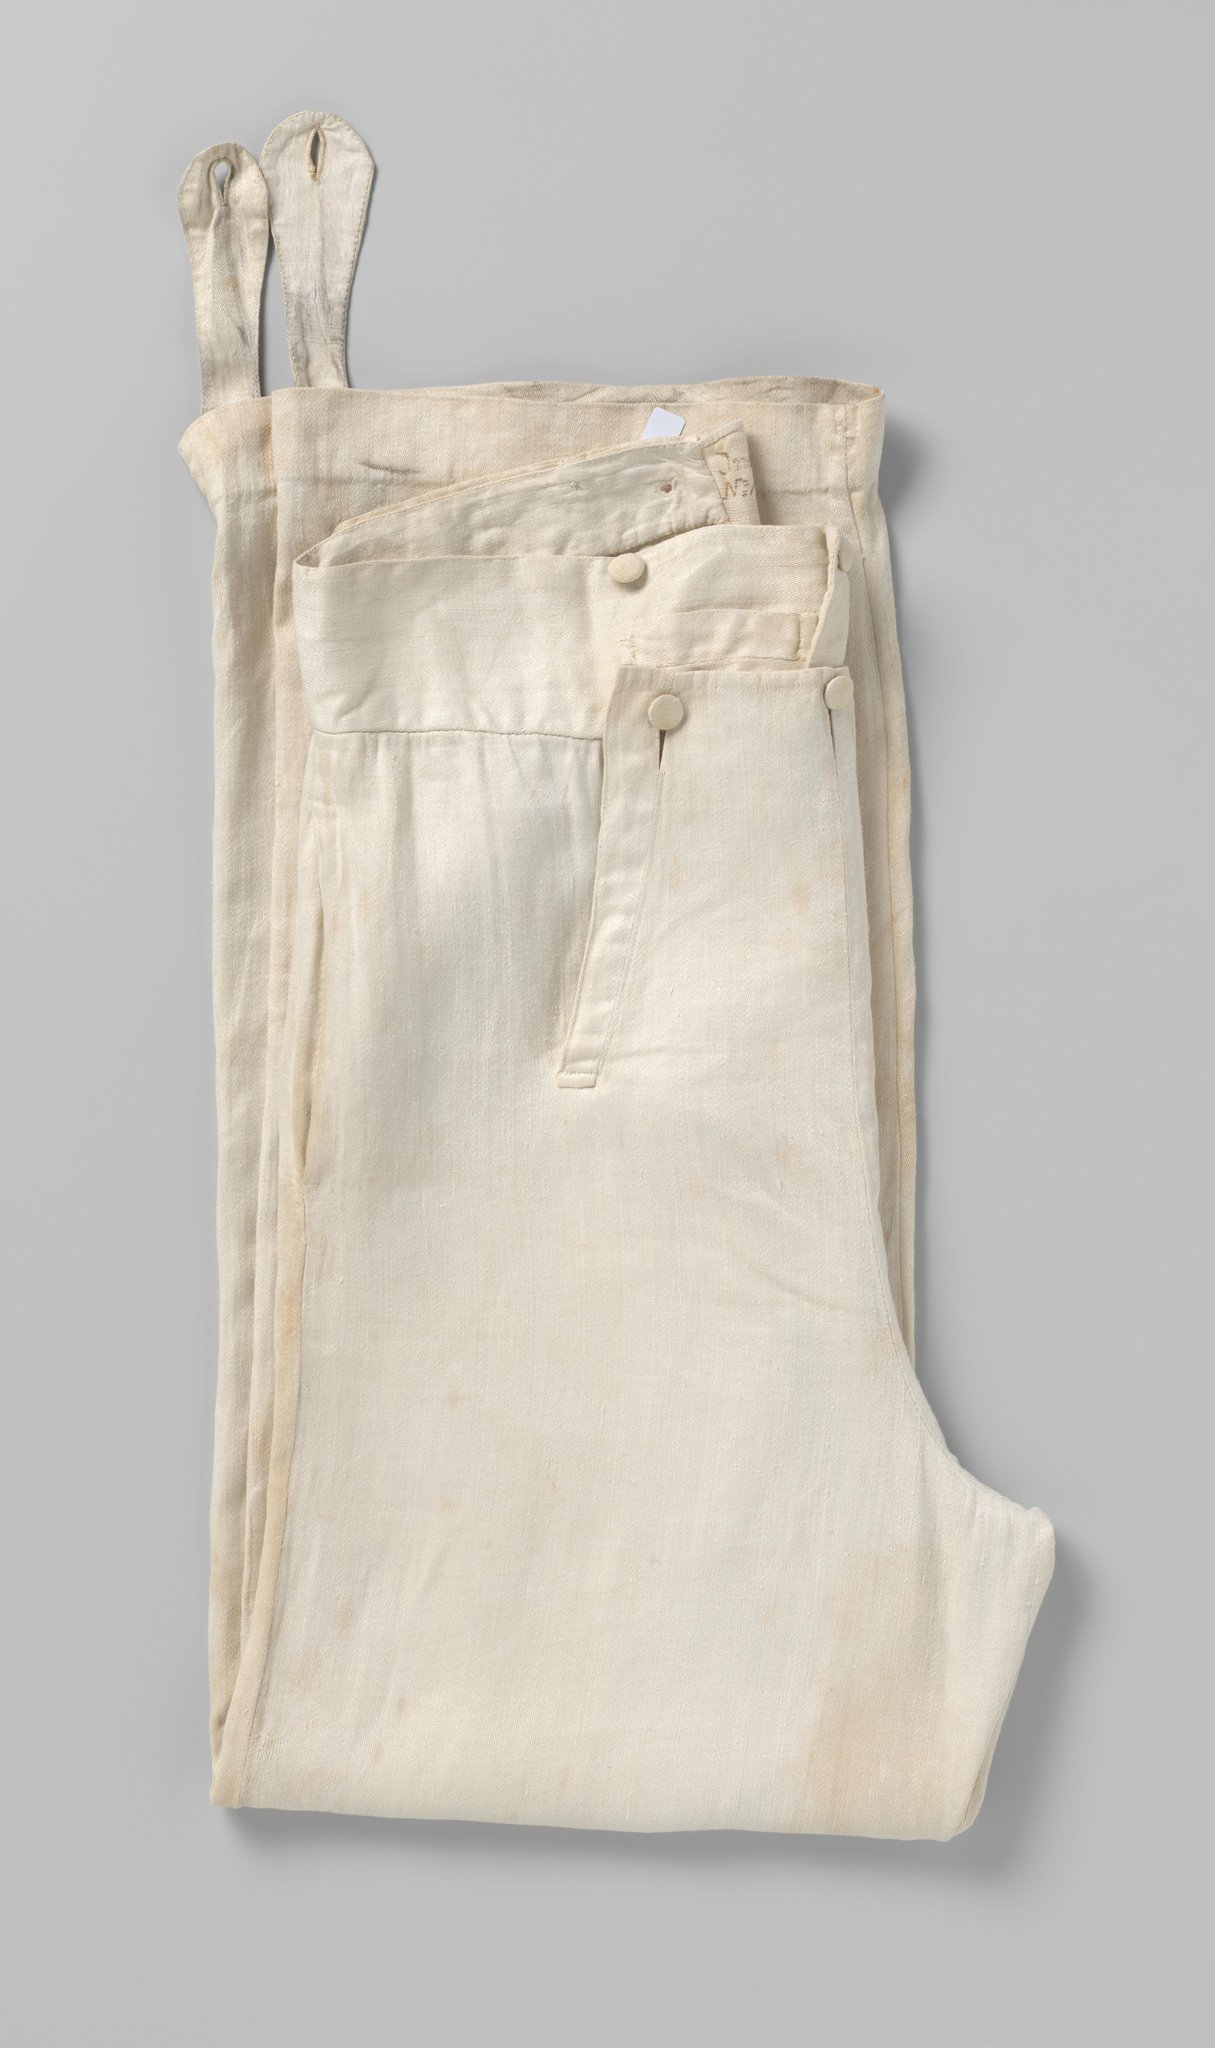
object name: menswear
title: Wit linnen broek met souspieds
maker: Anonymous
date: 1800-1850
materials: linen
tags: vught, overveen, minister, staatsman, intendant-generaal van financien, secretaris van staat voor financien, minister van financiën, izaak jean alexandre gogel